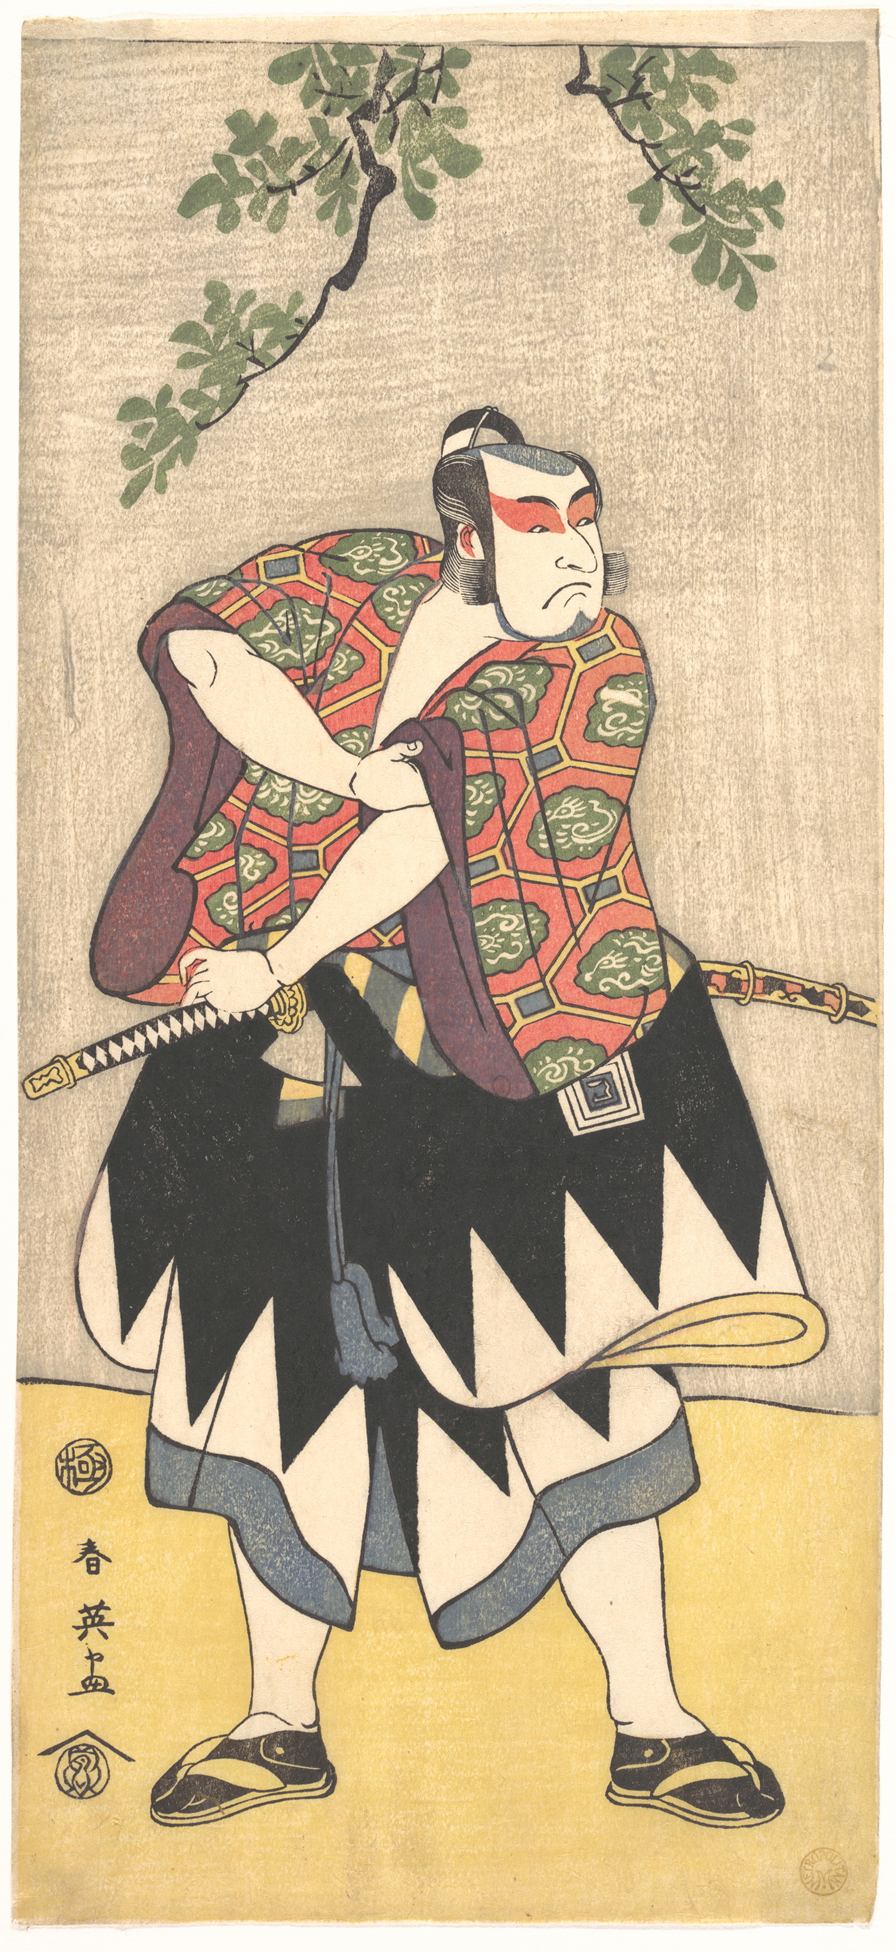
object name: woodblock print nishiki e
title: Kabuki Actor Ichikawa Monnosuke II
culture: japanese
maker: katsukawa shun'ei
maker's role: artist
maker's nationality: japanese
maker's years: 1762-1819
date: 1793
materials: ink, paper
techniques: nishiki e, woodblock print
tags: men,actors